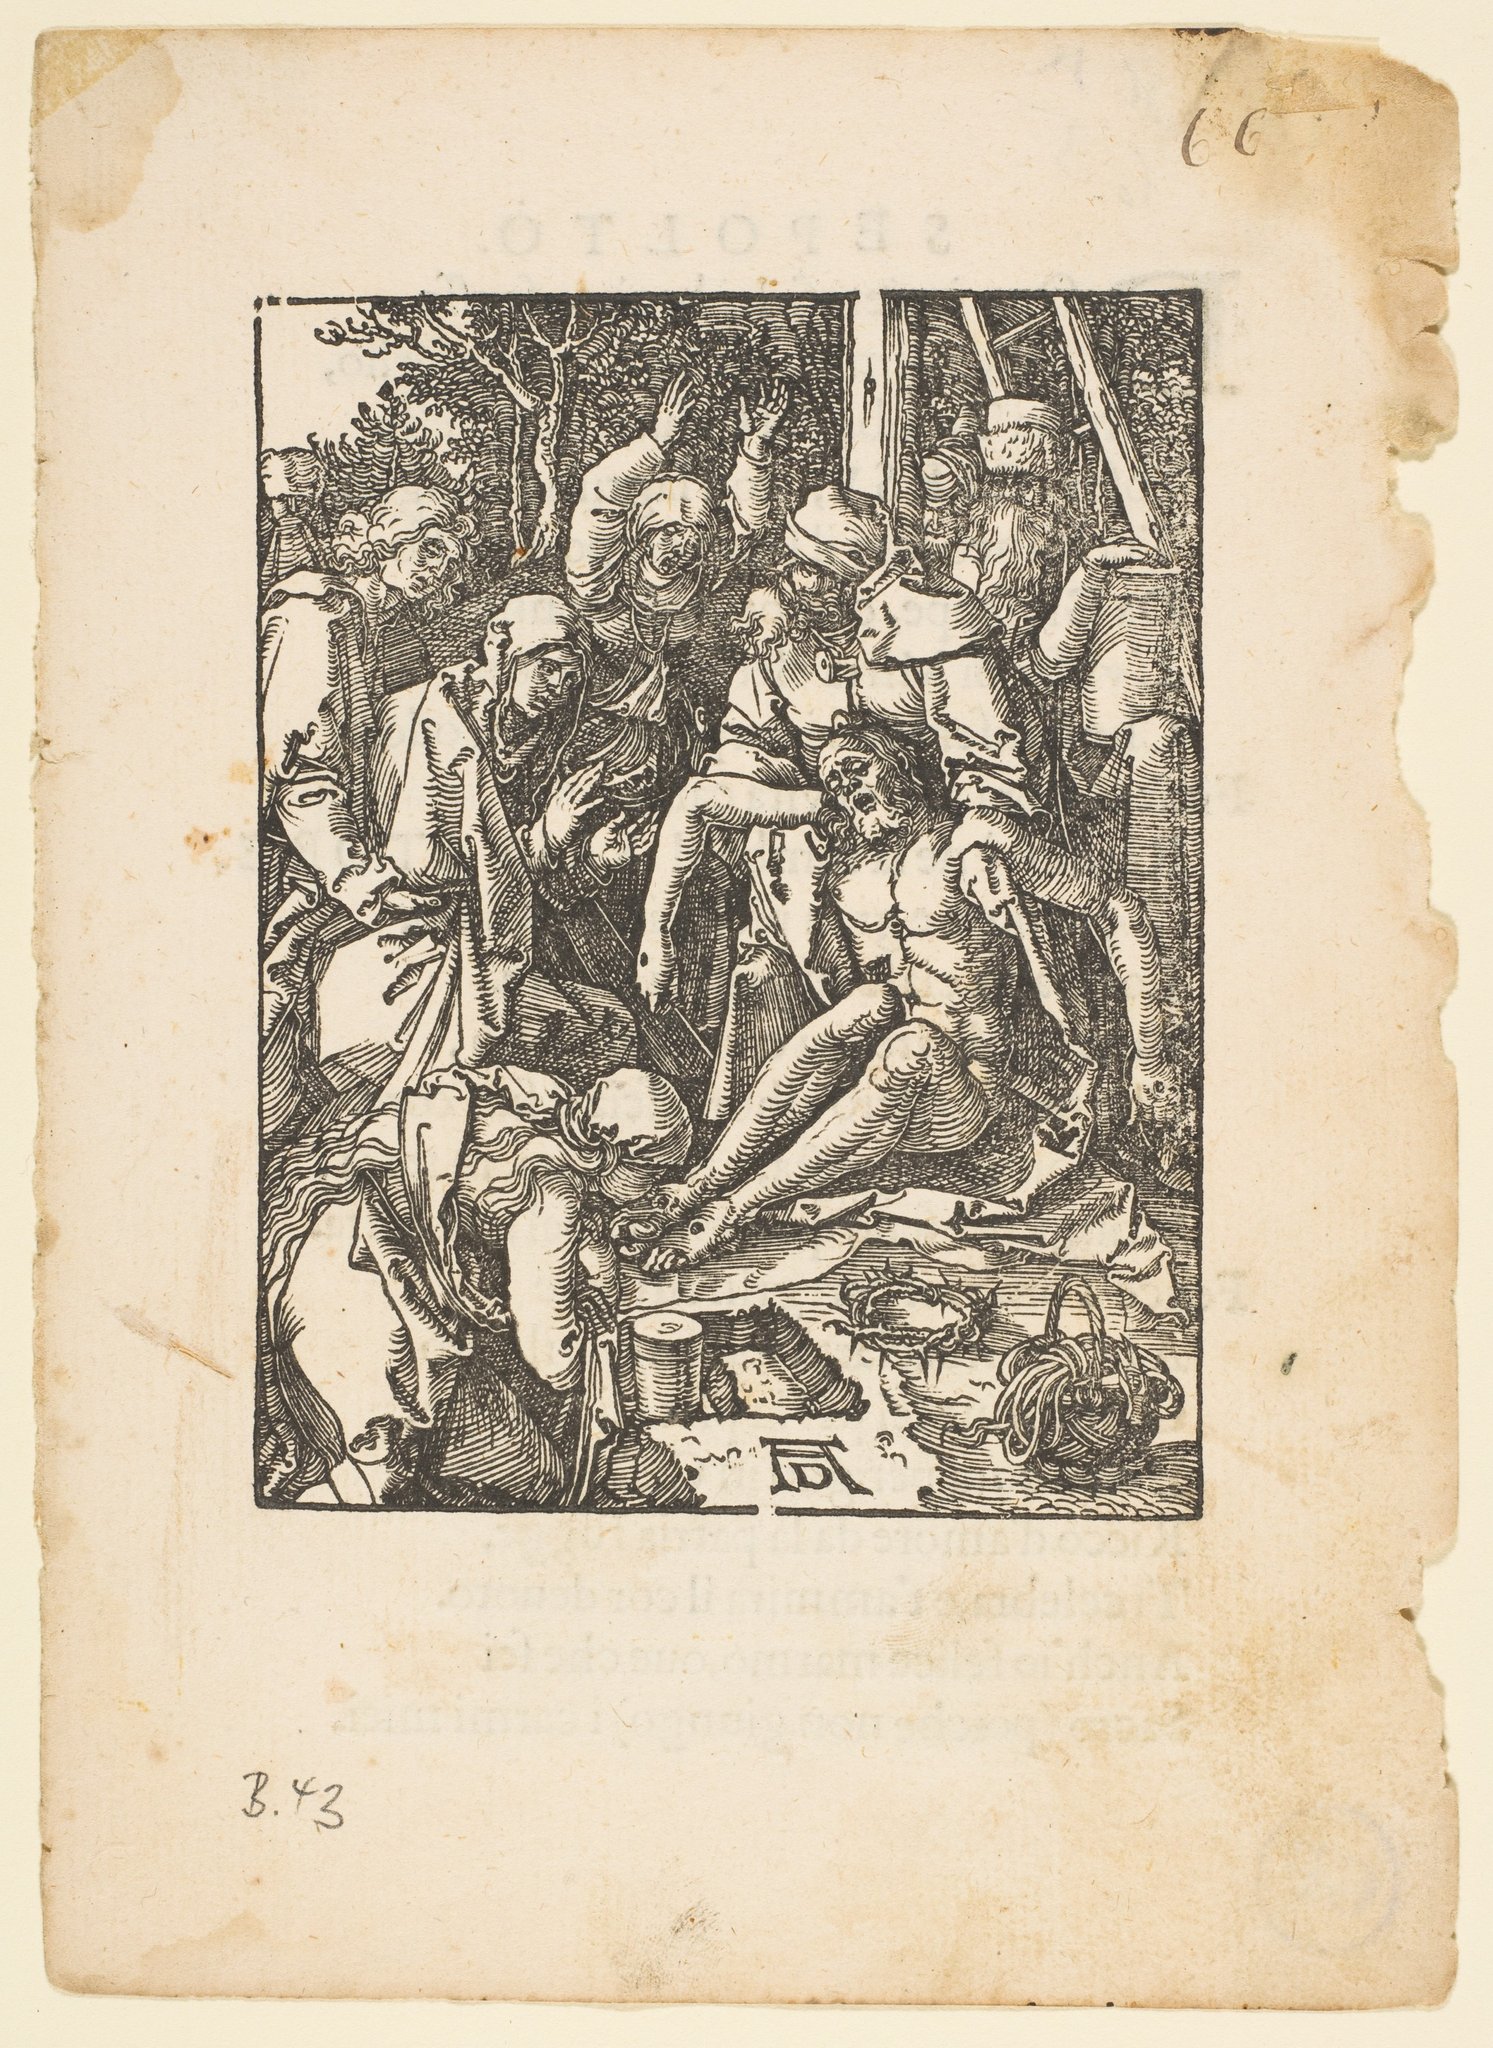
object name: print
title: The Lamentation, from "The Small Passion", edition Venice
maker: albrecht dürer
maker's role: artist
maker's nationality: german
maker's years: 1471-1528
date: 1612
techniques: woodcut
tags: lamentation